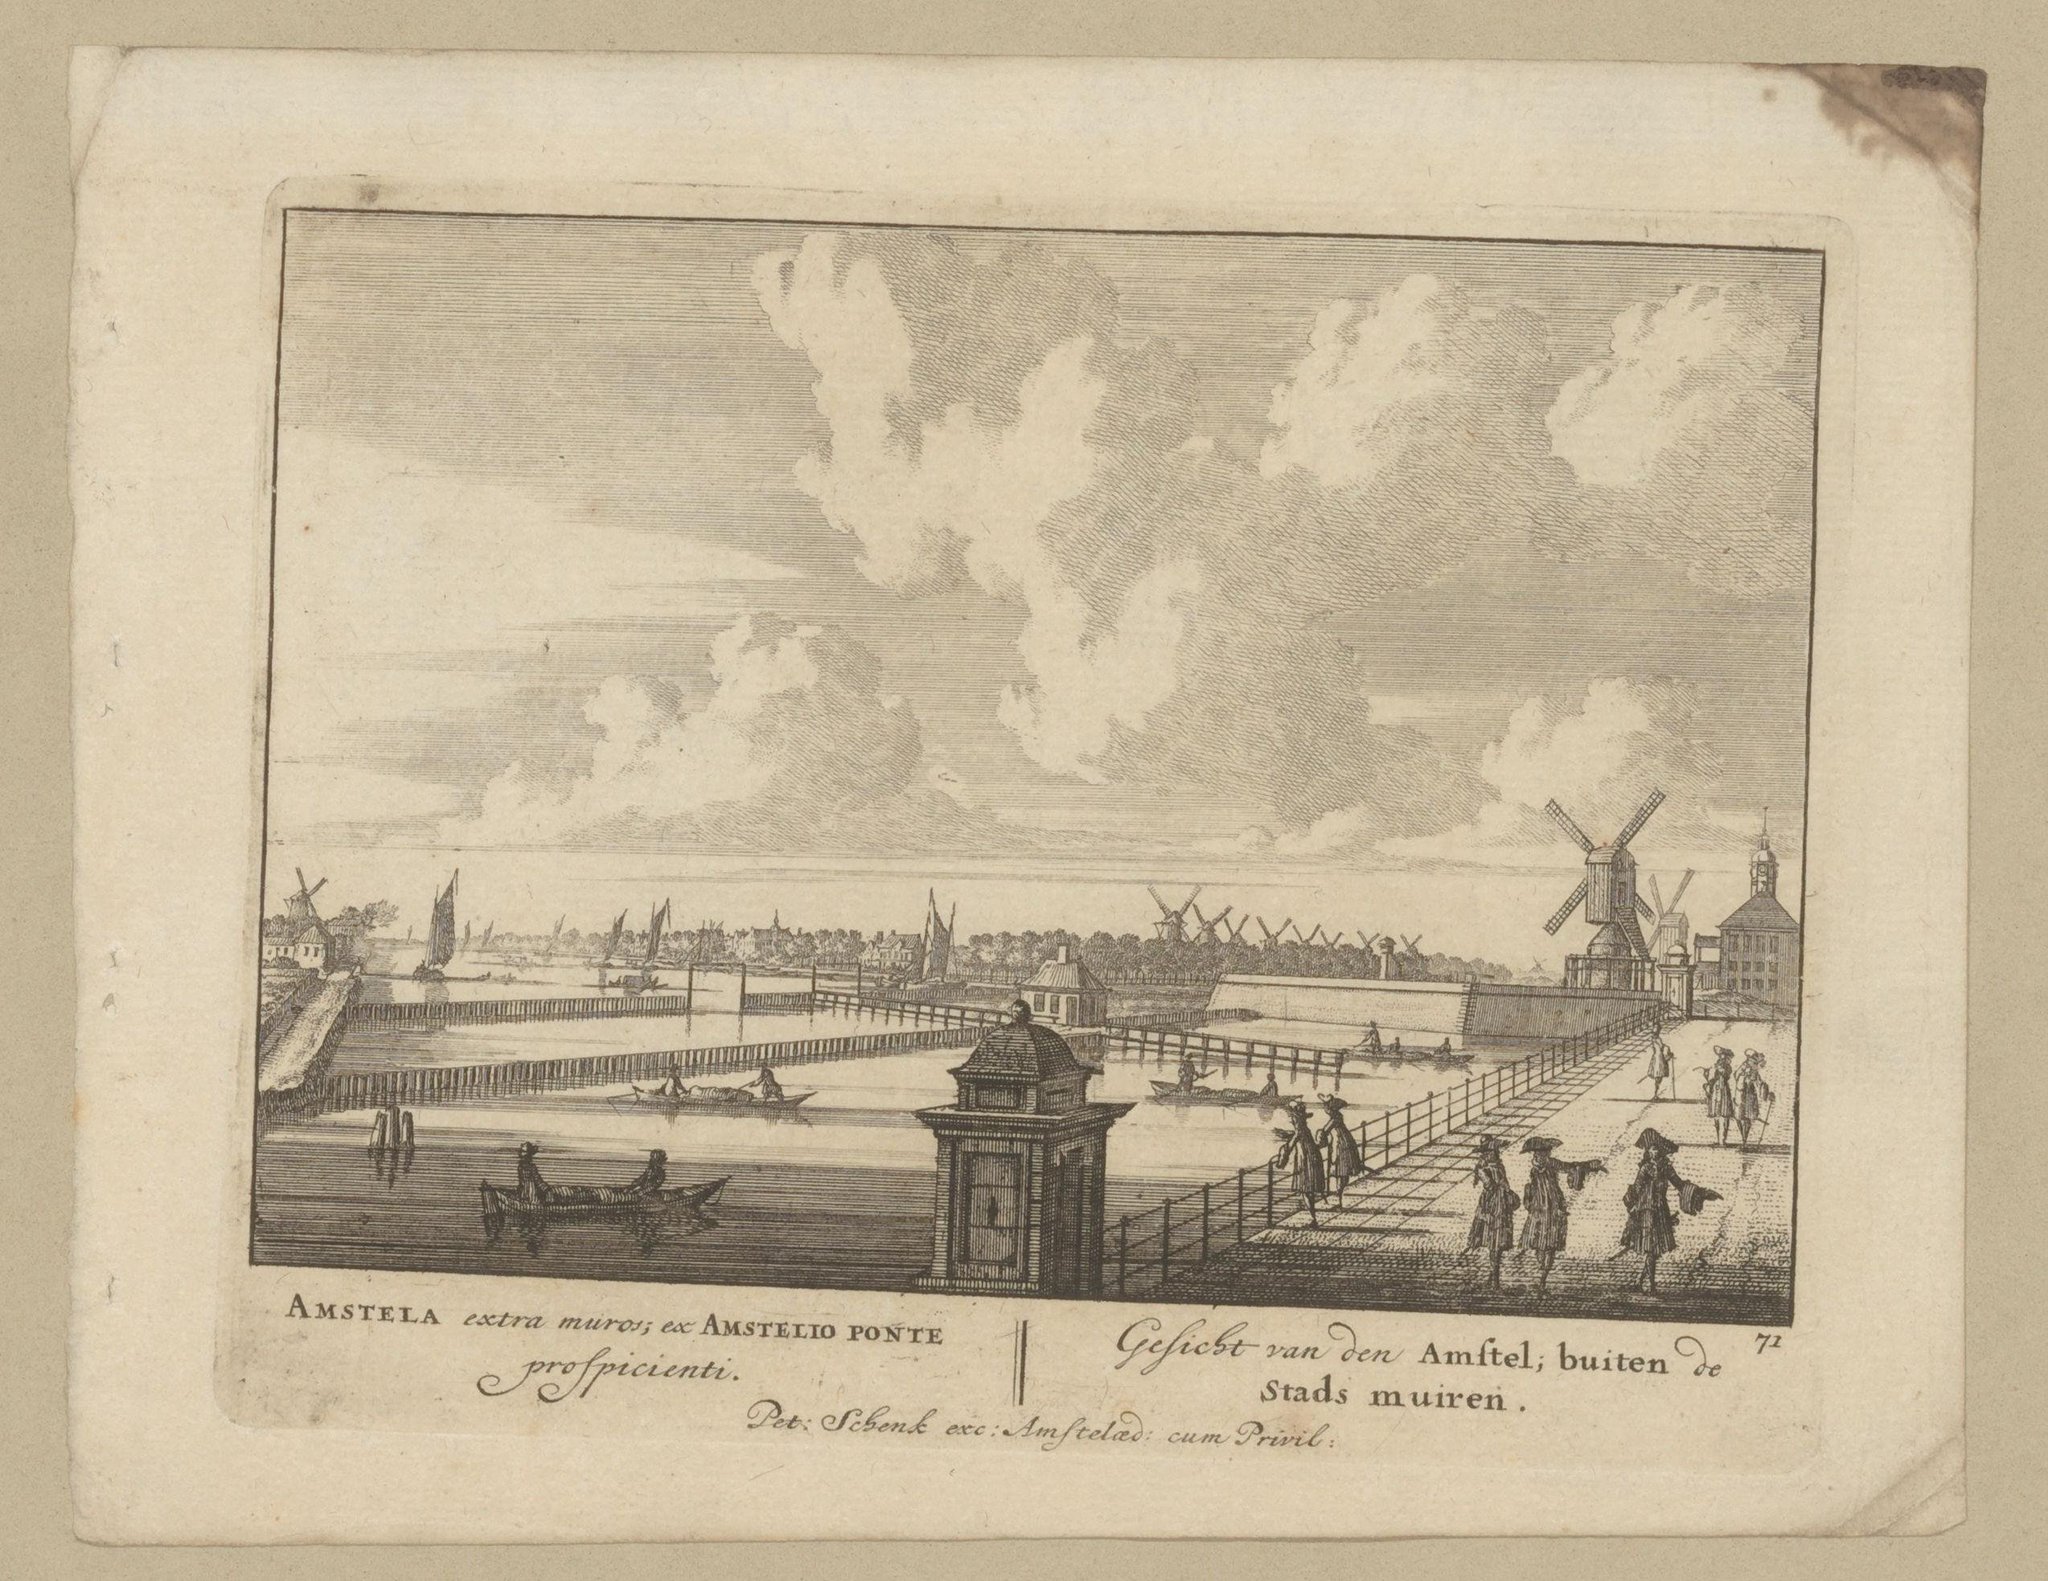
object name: print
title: Admirandorum Quadruplex Spectaculum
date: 1694-1697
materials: paper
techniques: etching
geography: amsterdam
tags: city-view in general; 'veduta', river, windmill in landscape, bridge in city across river, canal, etc.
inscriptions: collector's mark: ‘4’ Lugt 1641b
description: Andere staat ook gebruikt in: Call, Jan van. Admirandorum Quadruplex Spectaculum. Amsterdam: Pieter Schenk (I), 1700. De titelprent, opdracht en het portret van Frederik van Saksen zijn gegraveerd door Pieter Schenk (I). De overige prenten uit deze serie zijn, zoals aangegeven op de titelprent, van de hand van Jan van Call (I).